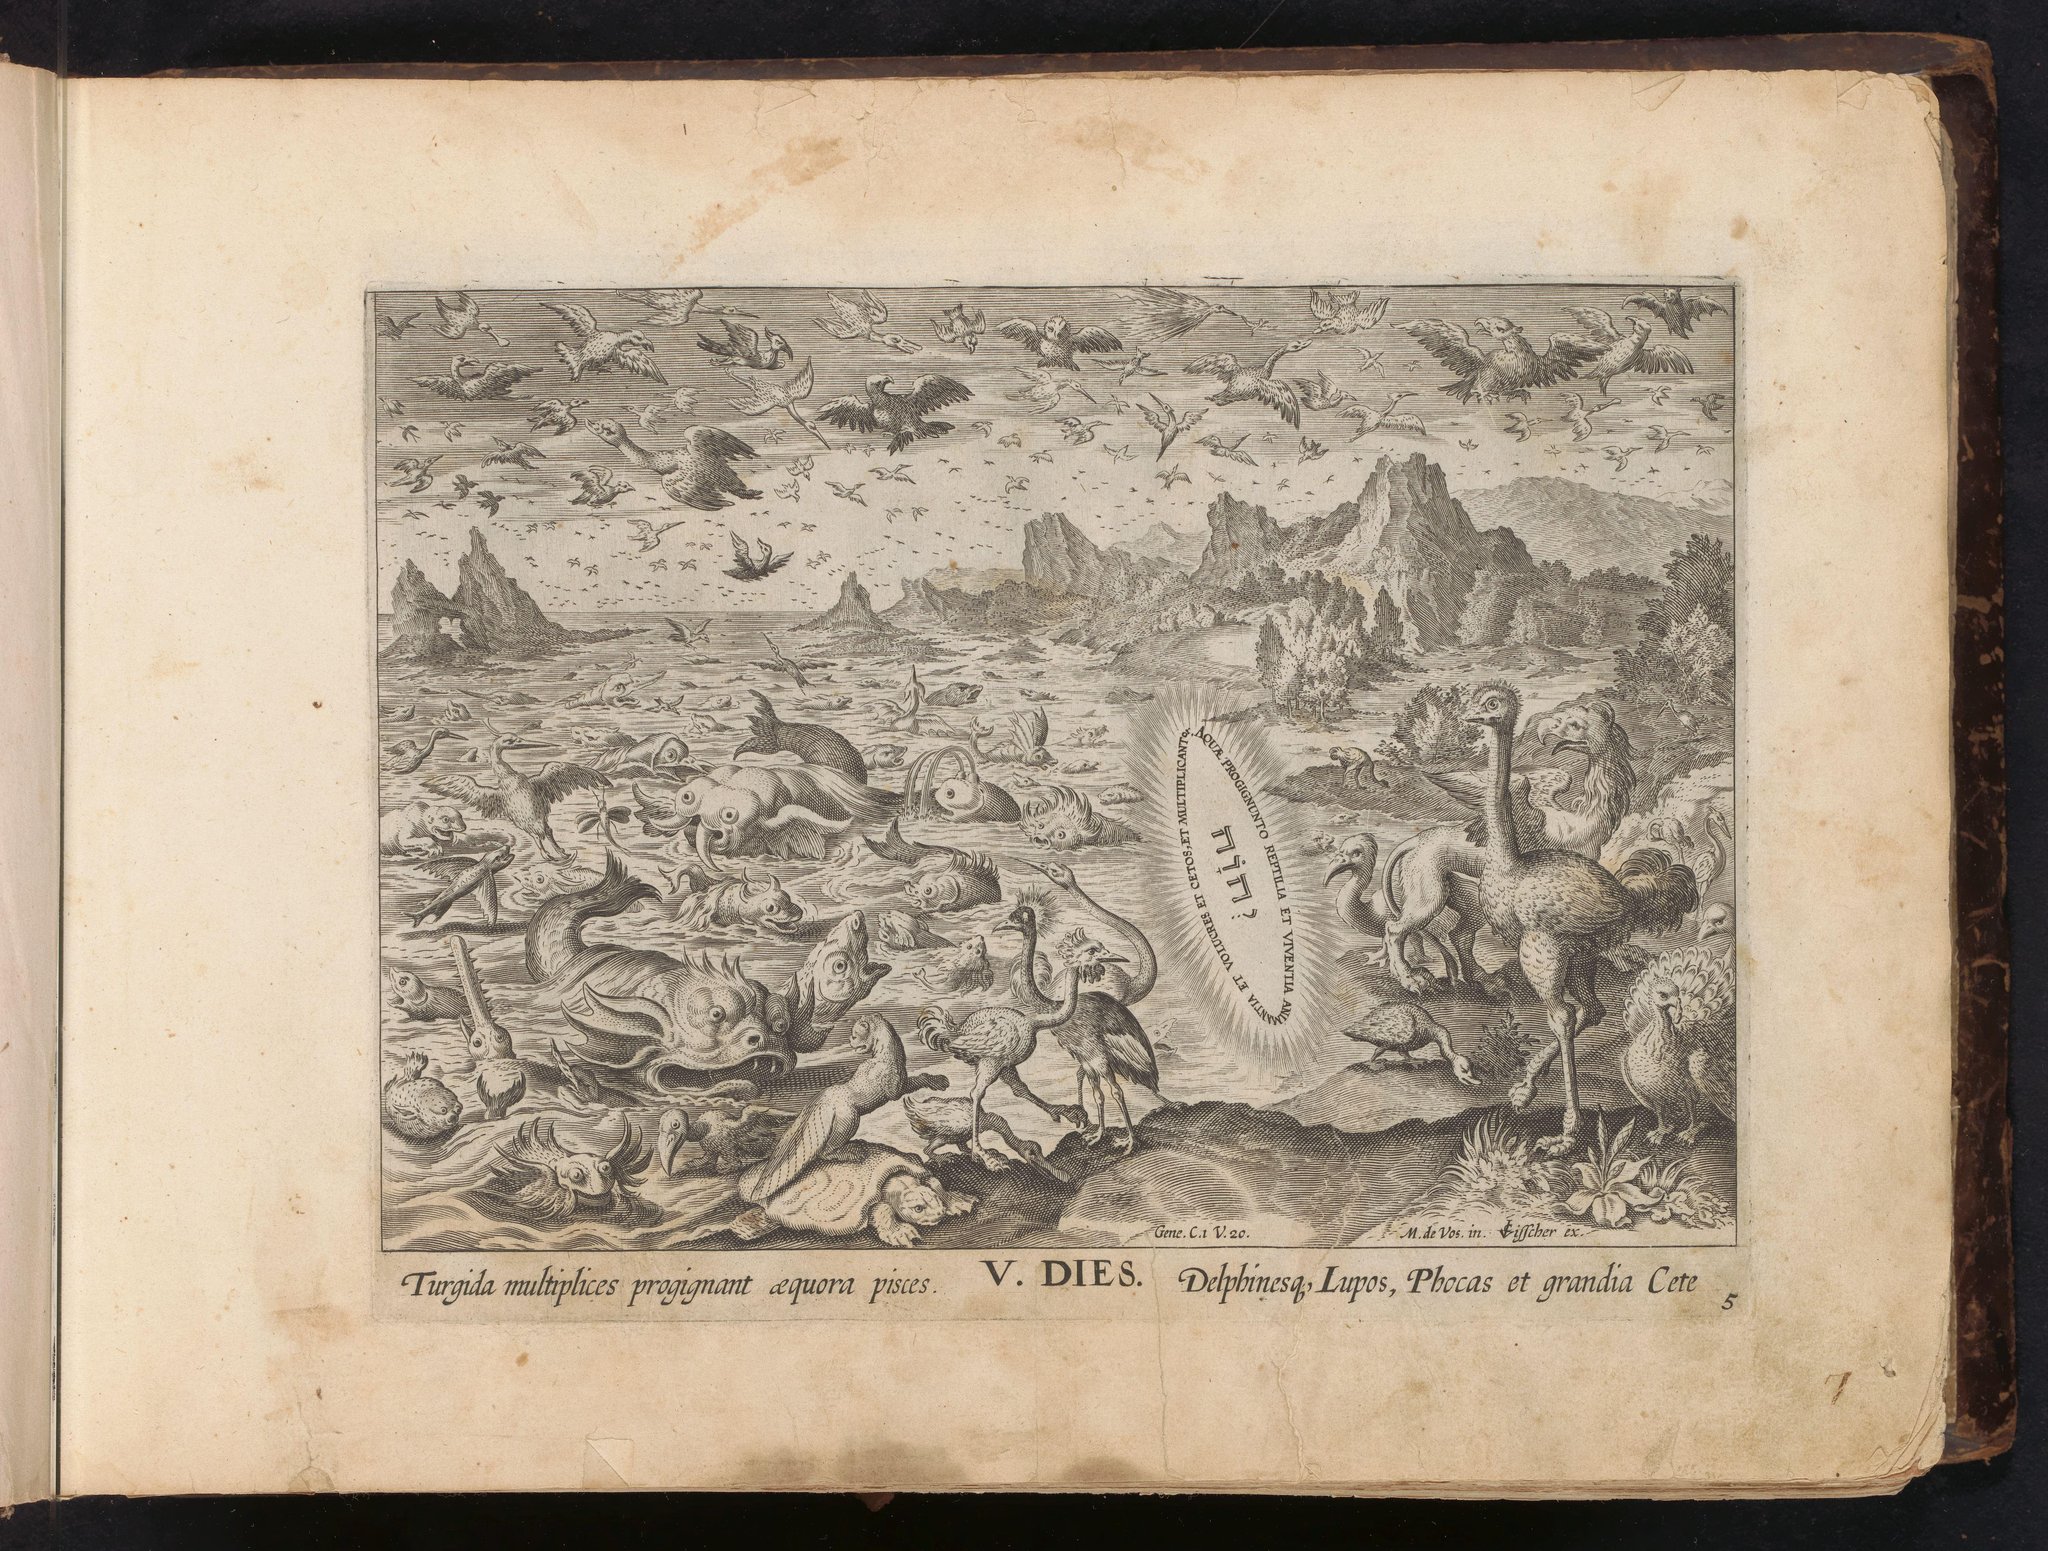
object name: album leaf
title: Den Grooten Figuer-Bibel (...)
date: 1639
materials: paper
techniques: engraving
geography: amsterdam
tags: tortoises, turtles, fishes, tetragram (in roman or hebrew script) ~ symbol of god the father, creation of the animals ~ genesis, moon as celestial body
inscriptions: number: ‘7’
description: Op de voorgrond God de Vader in de vorm van een tetragram. Voor hem zwemmen zeedieren in het water. Op het land en in de lucht verschillende vogels. Op de vijfde dag van de schepping schiep God de vogels in de lucht en de dieren in het water. Onder de voorstelling een verwijzing in het Latijn naar de Bijbeltekst in Gen. 1:20. Deze prent maakt deel uit van een album.